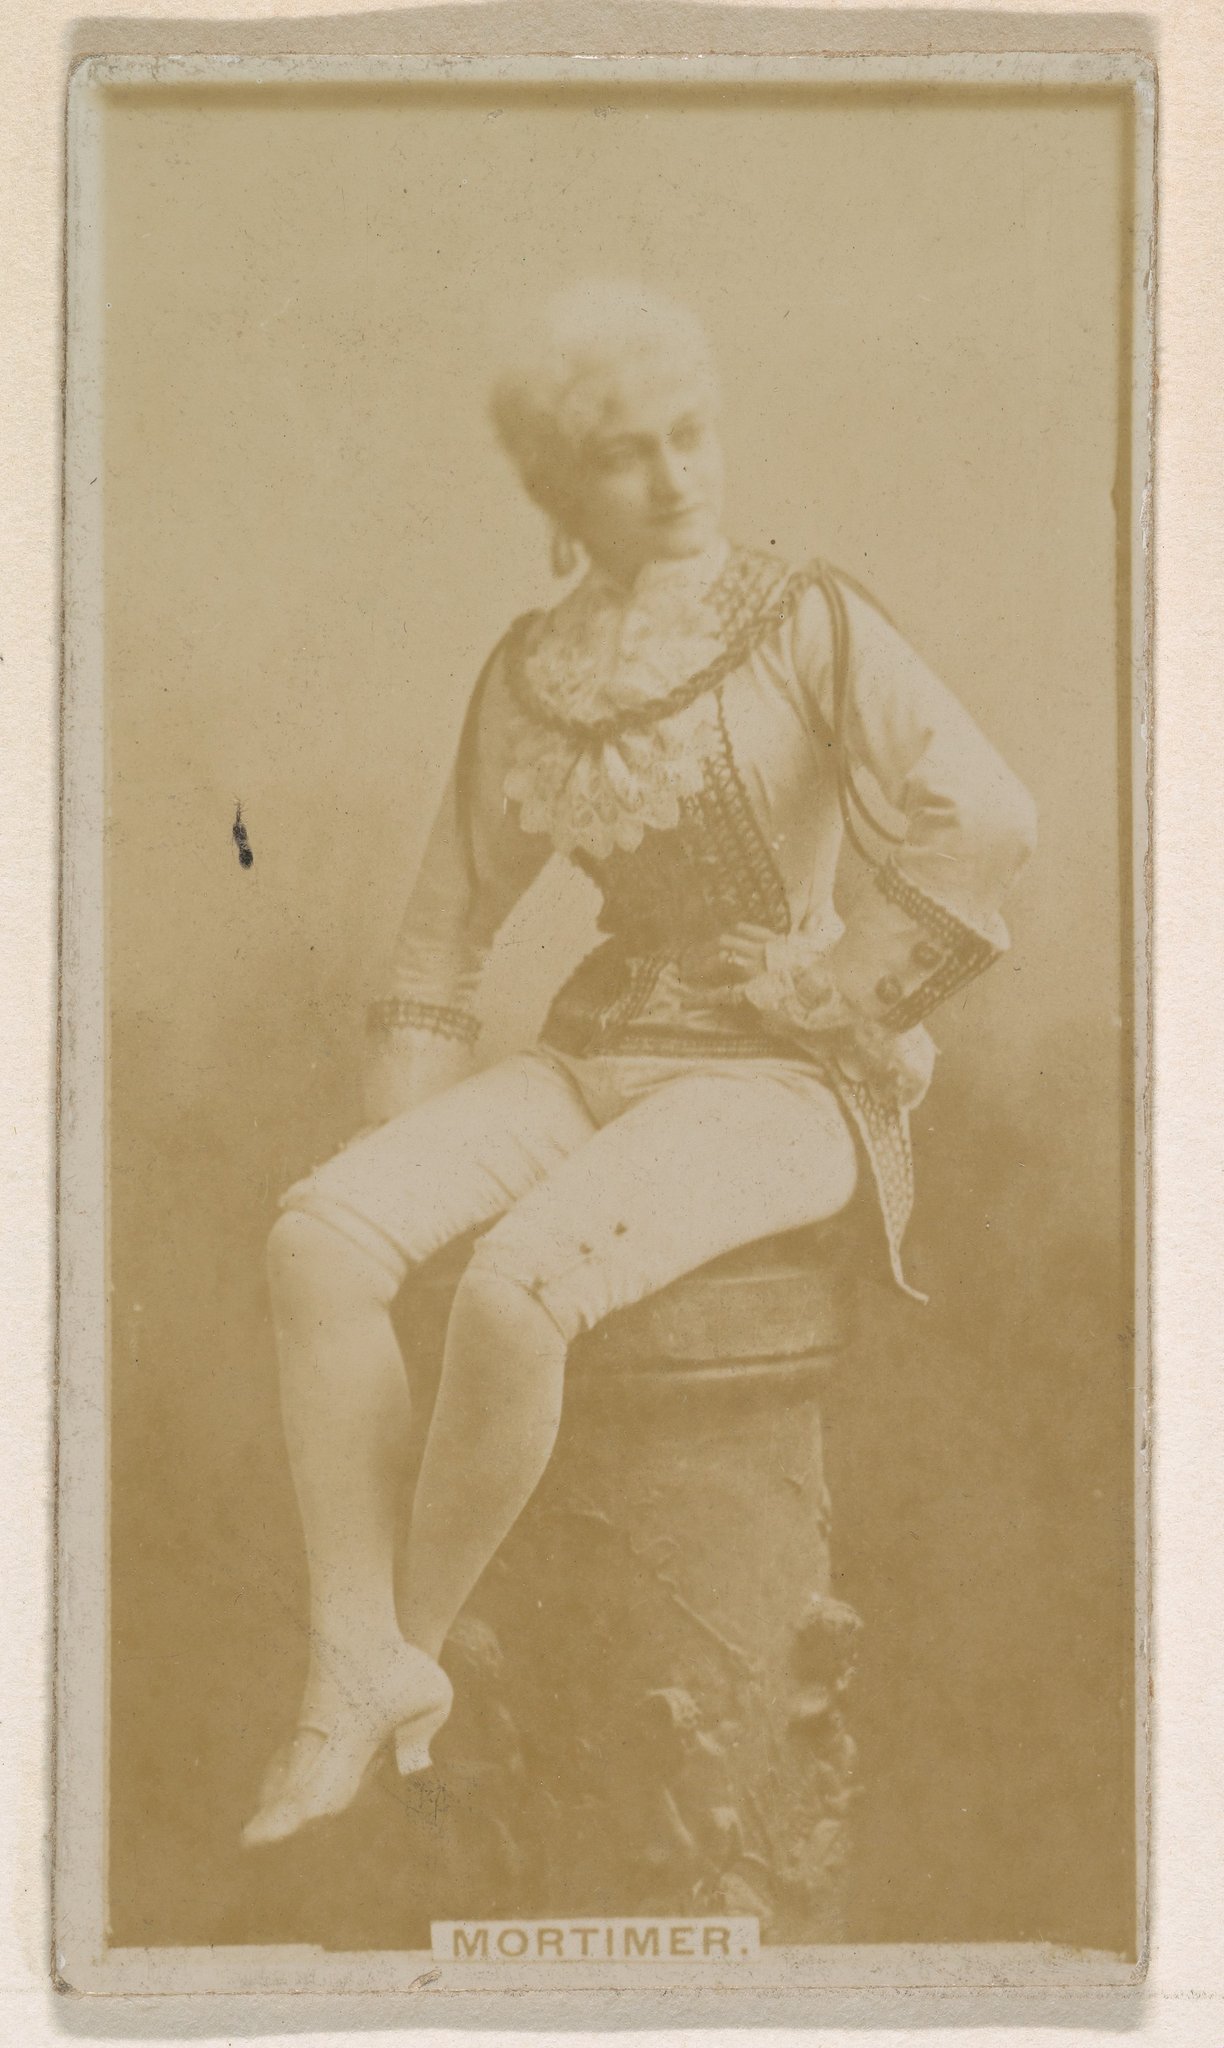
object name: photograph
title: Miss Mortimer, from the Actresses series (N245) issued by Kinney Brothers to promote Sweet Caporal Cigarettes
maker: kinney brothers tobacco company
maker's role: publisher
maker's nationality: american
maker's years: 1869-2011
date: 1890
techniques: albumen silver print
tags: portraits,women,actresses